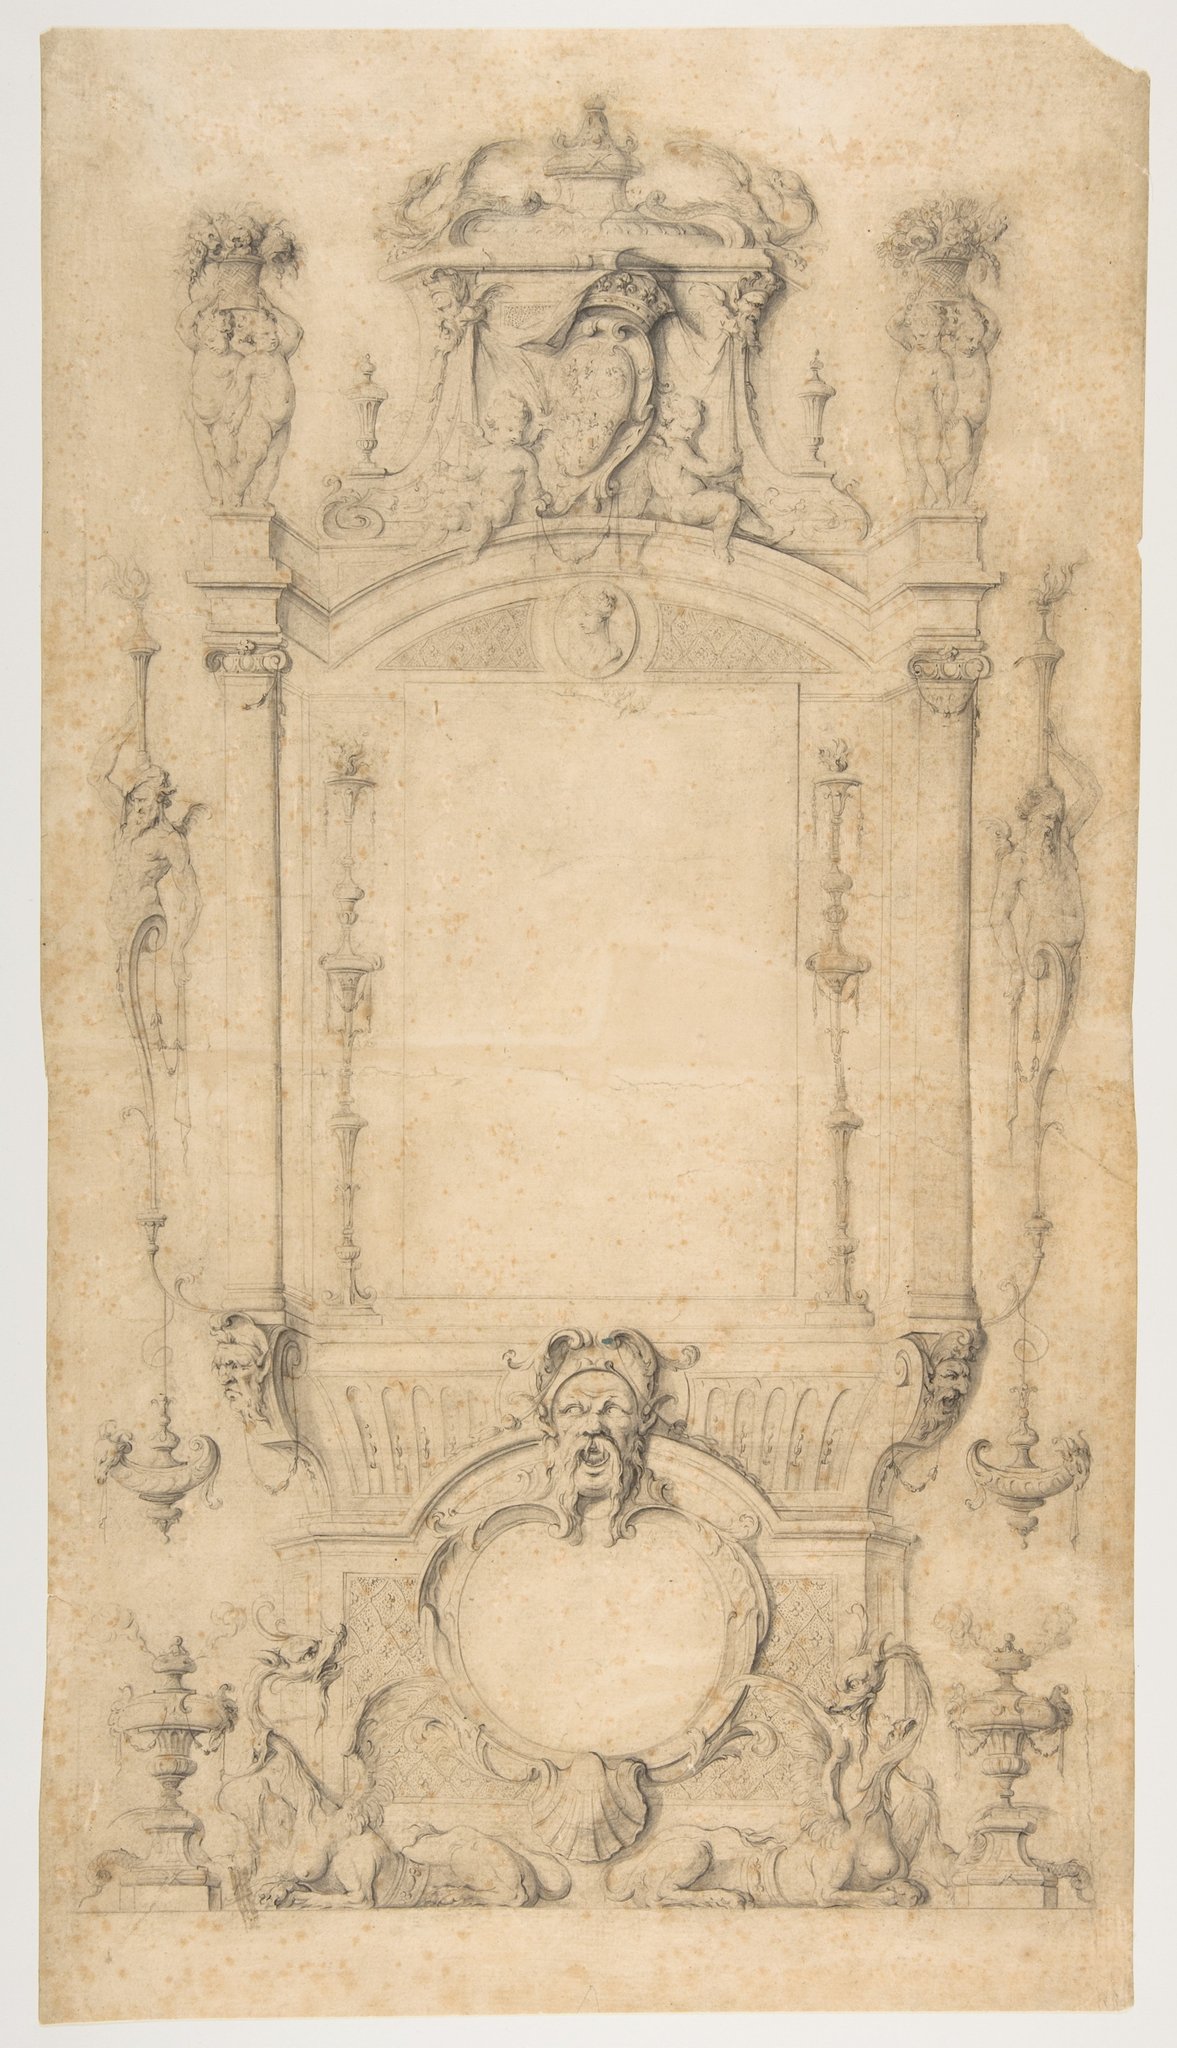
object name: drawing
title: Design for a title page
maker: jean bernard toro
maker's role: artist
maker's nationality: french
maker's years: 1672-1731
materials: ink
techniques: brush, pen, wash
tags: ornament,putti,coat of arms